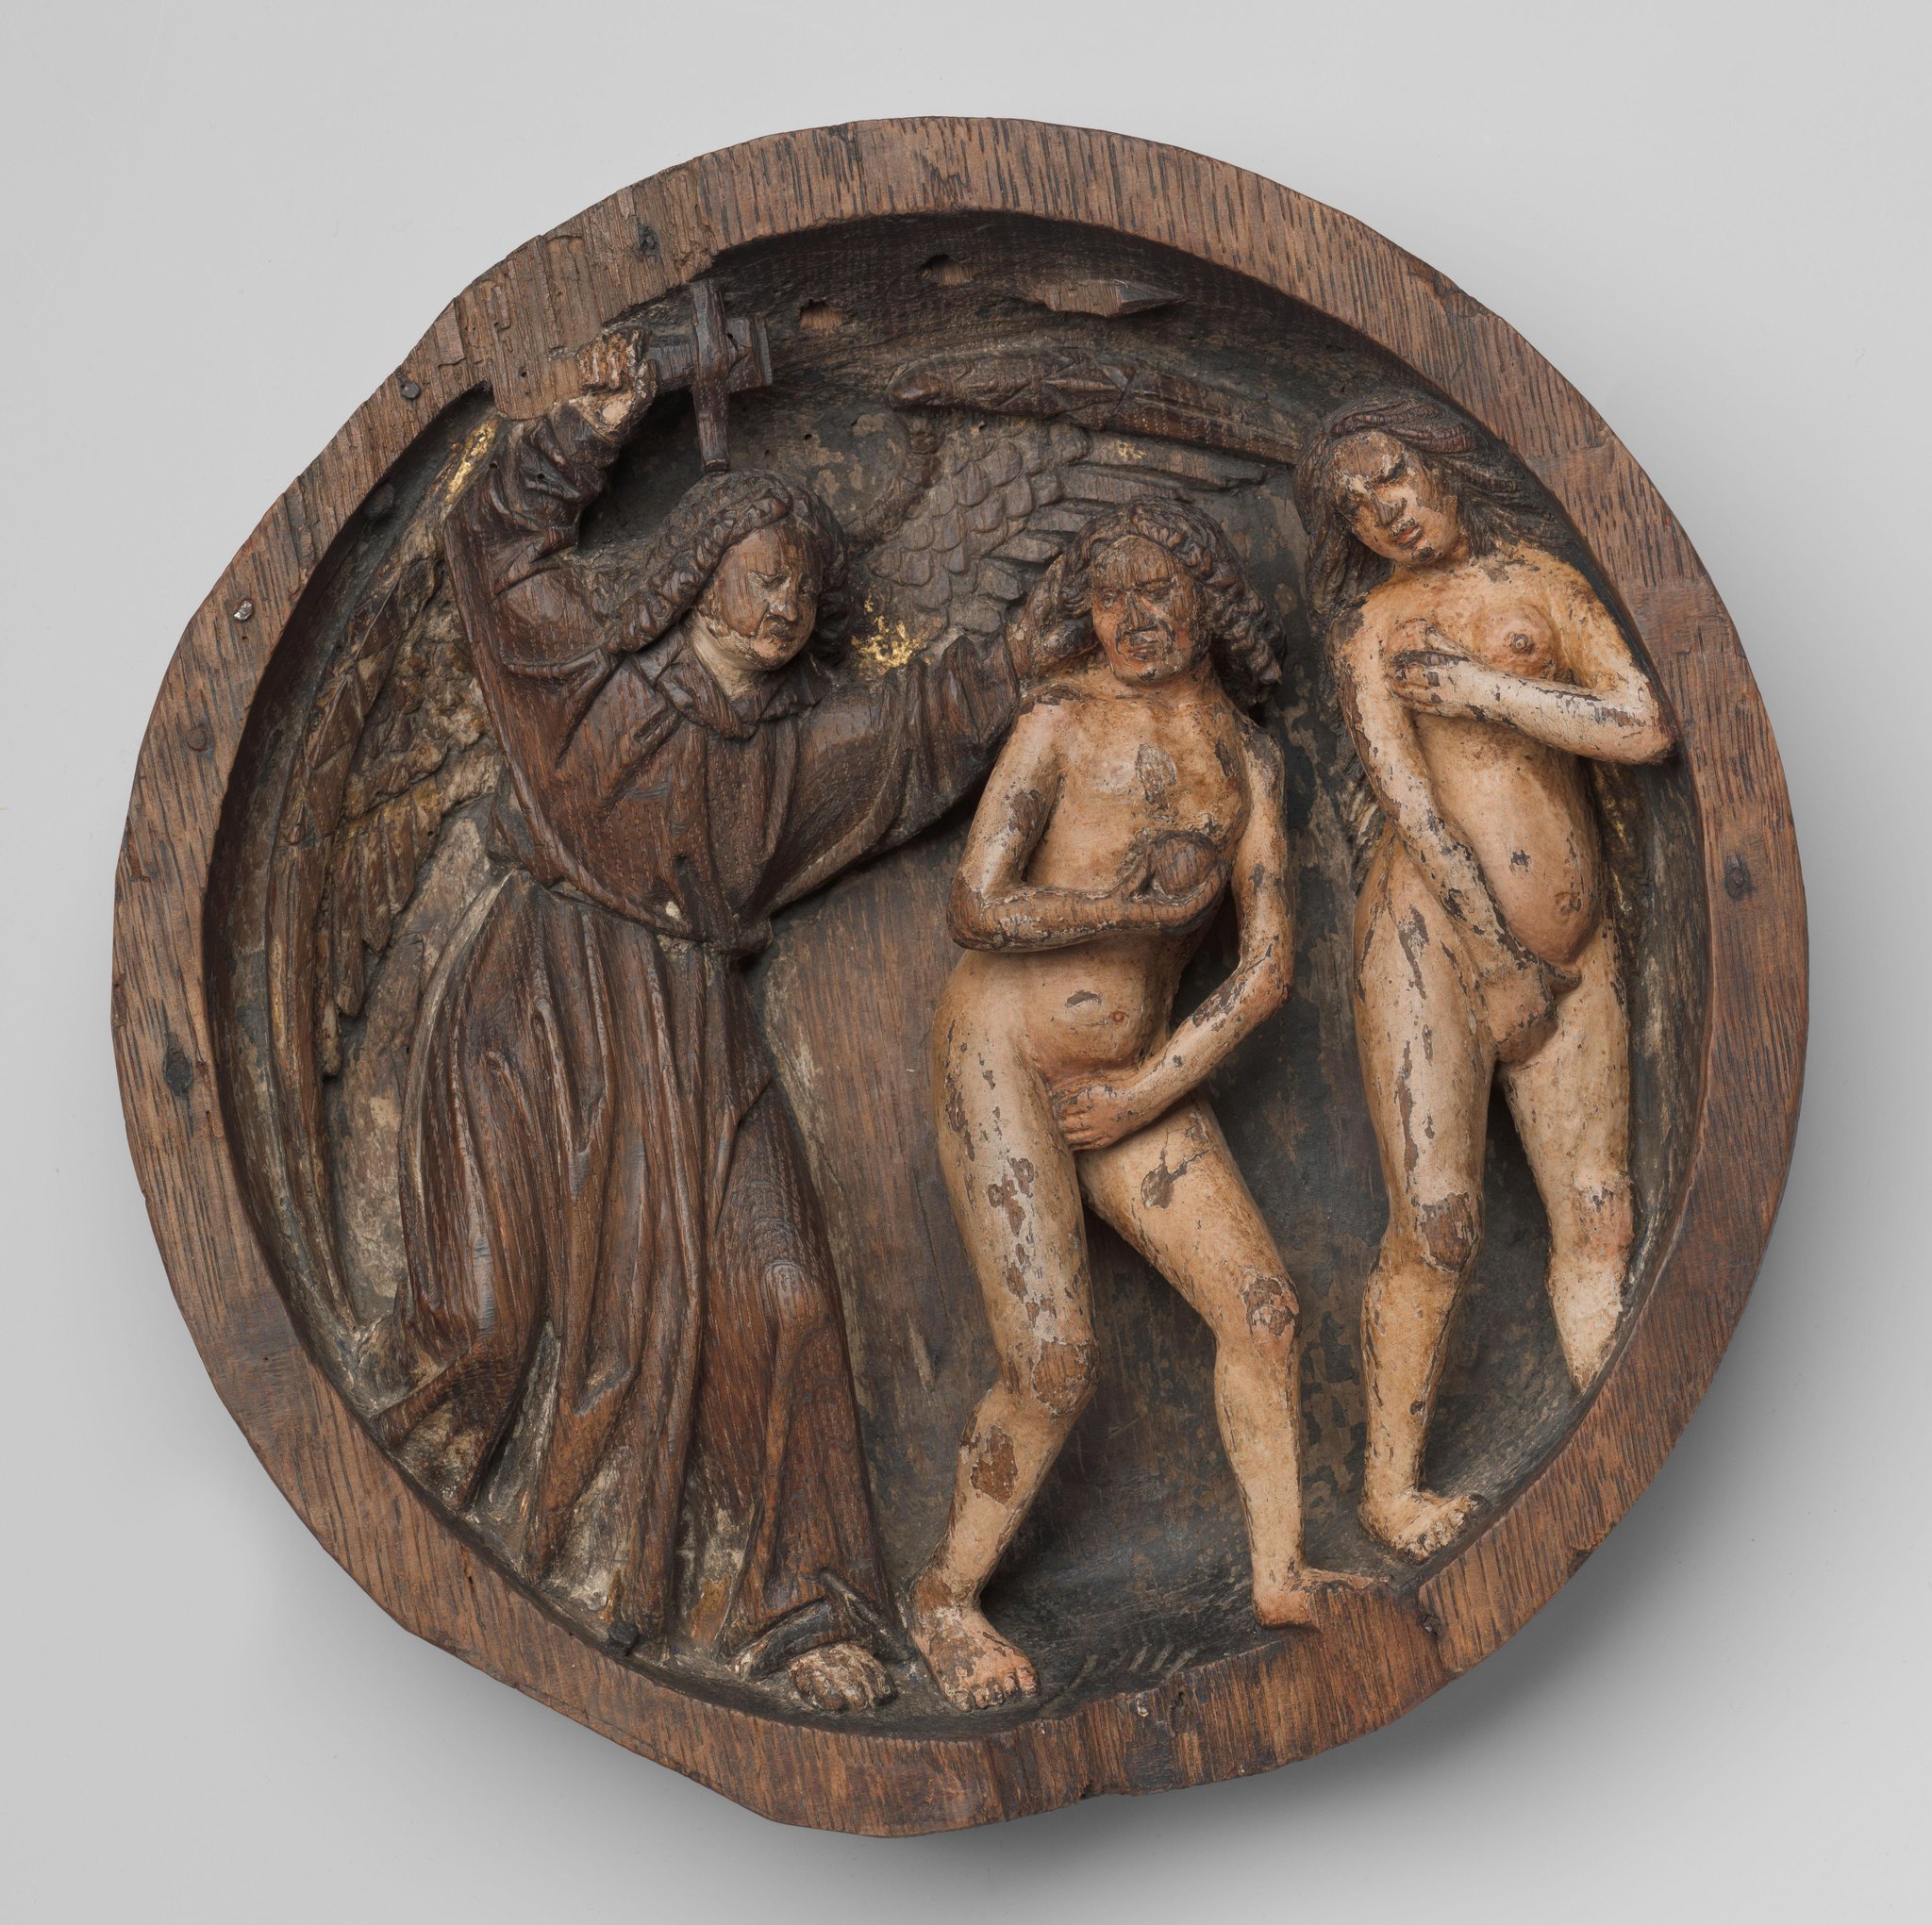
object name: sculpture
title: Expulsion from Paradise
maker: Anonymous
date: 1500-1515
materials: wood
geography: antwerp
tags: expulsion of adam and eve from paradise (genesis 3:22-24)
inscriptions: mark, on the raised border front bottom, branded: a hand (the Antwerp wood quality mark)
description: The Expulsion from Paradise. Oak with remains of old polychromy. Antwerp, c. 1500.